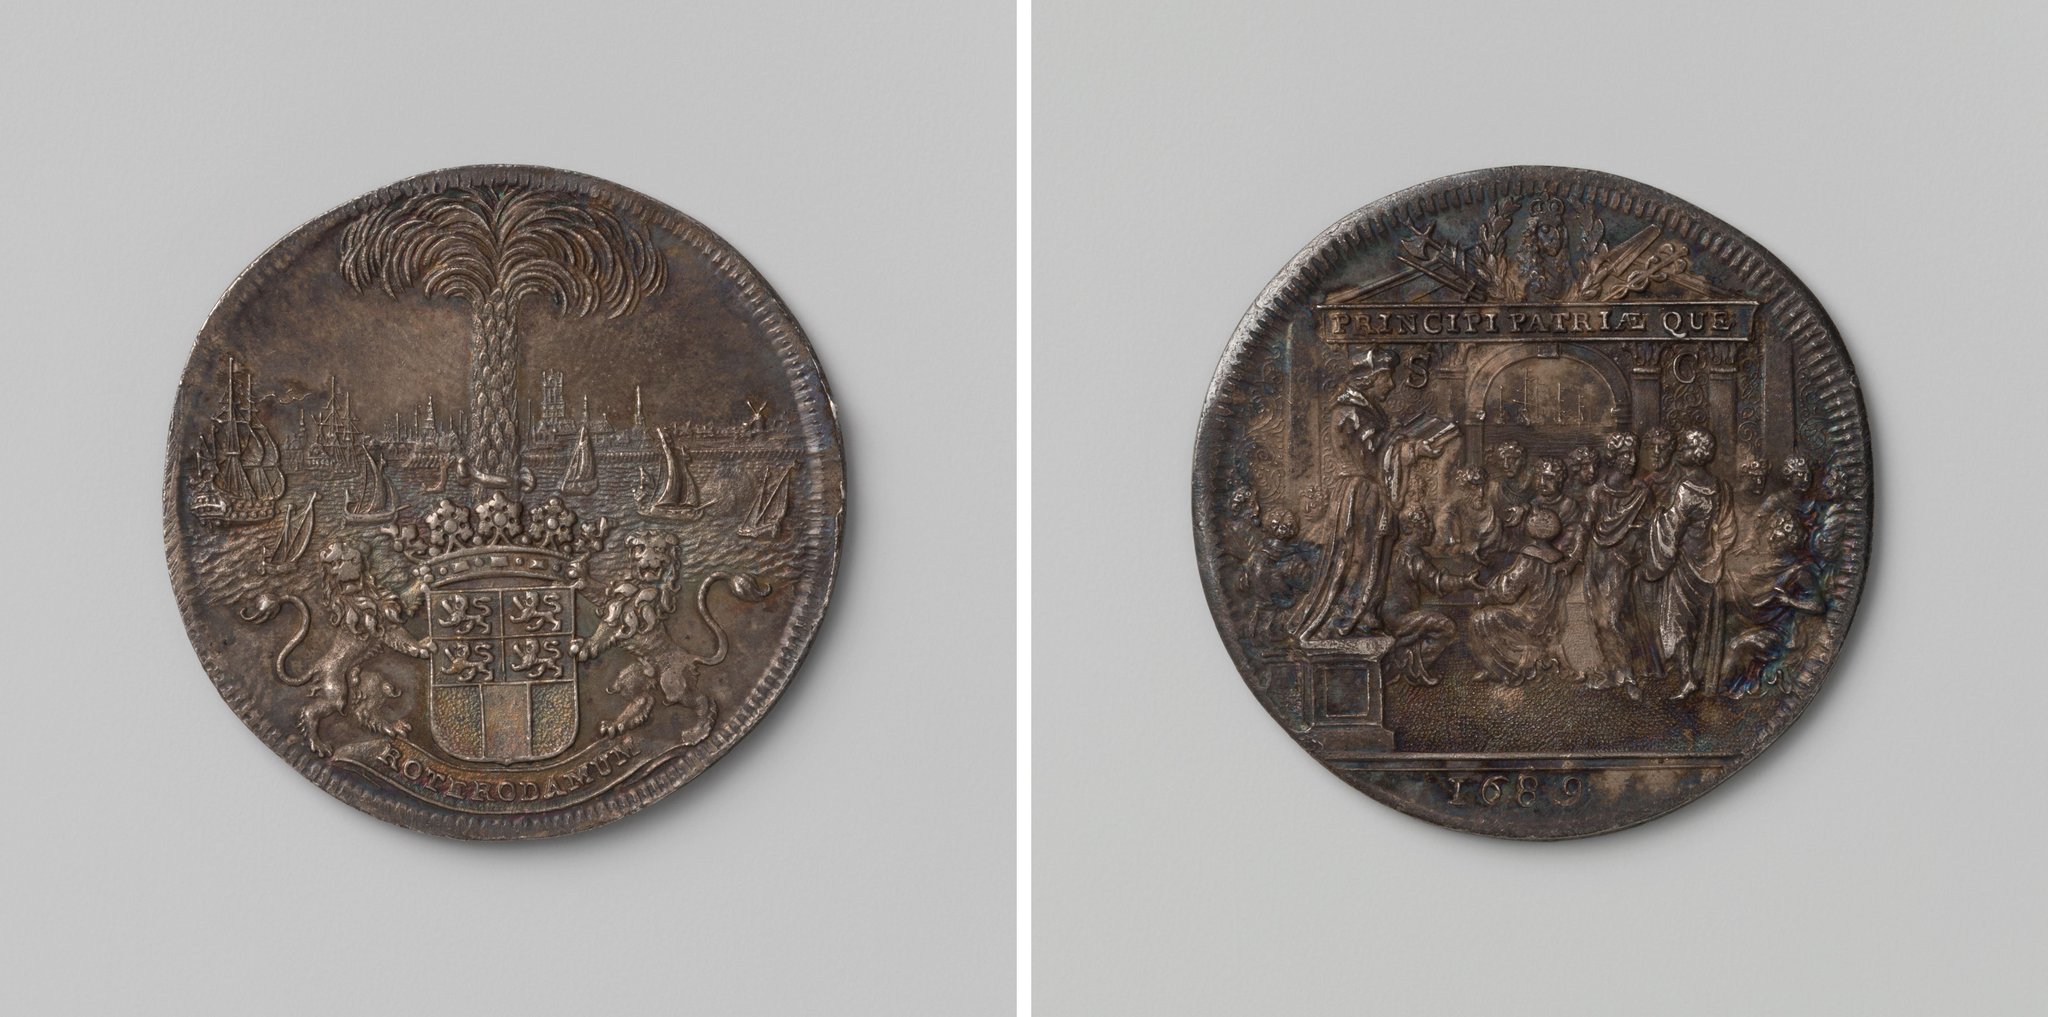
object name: council medal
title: Viering van de kroning van Willem III en Maria te Rotterdam, penning geslagen op last van het stadsbestuur van Rotterdam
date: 1689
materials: silver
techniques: striking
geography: dordrecht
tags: the hague, william iii (prince of orange and king of england, scotland, and ireland), london, maria ii stuart (koningin van engeland, schotland en ierland), rotterdam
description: Zilveren penning met gat. Voorzijde: gekroond wapenschild opgehouden door twee leeuwen boven wimpel met opschrift, op achtergrond palmboom en stad aan haven. Keerzijde: groep mensen bij standbeeld van Erasmus voor opgerichte triomfboog met daarop opschrift en gekroond borstbeeld van Willem III.